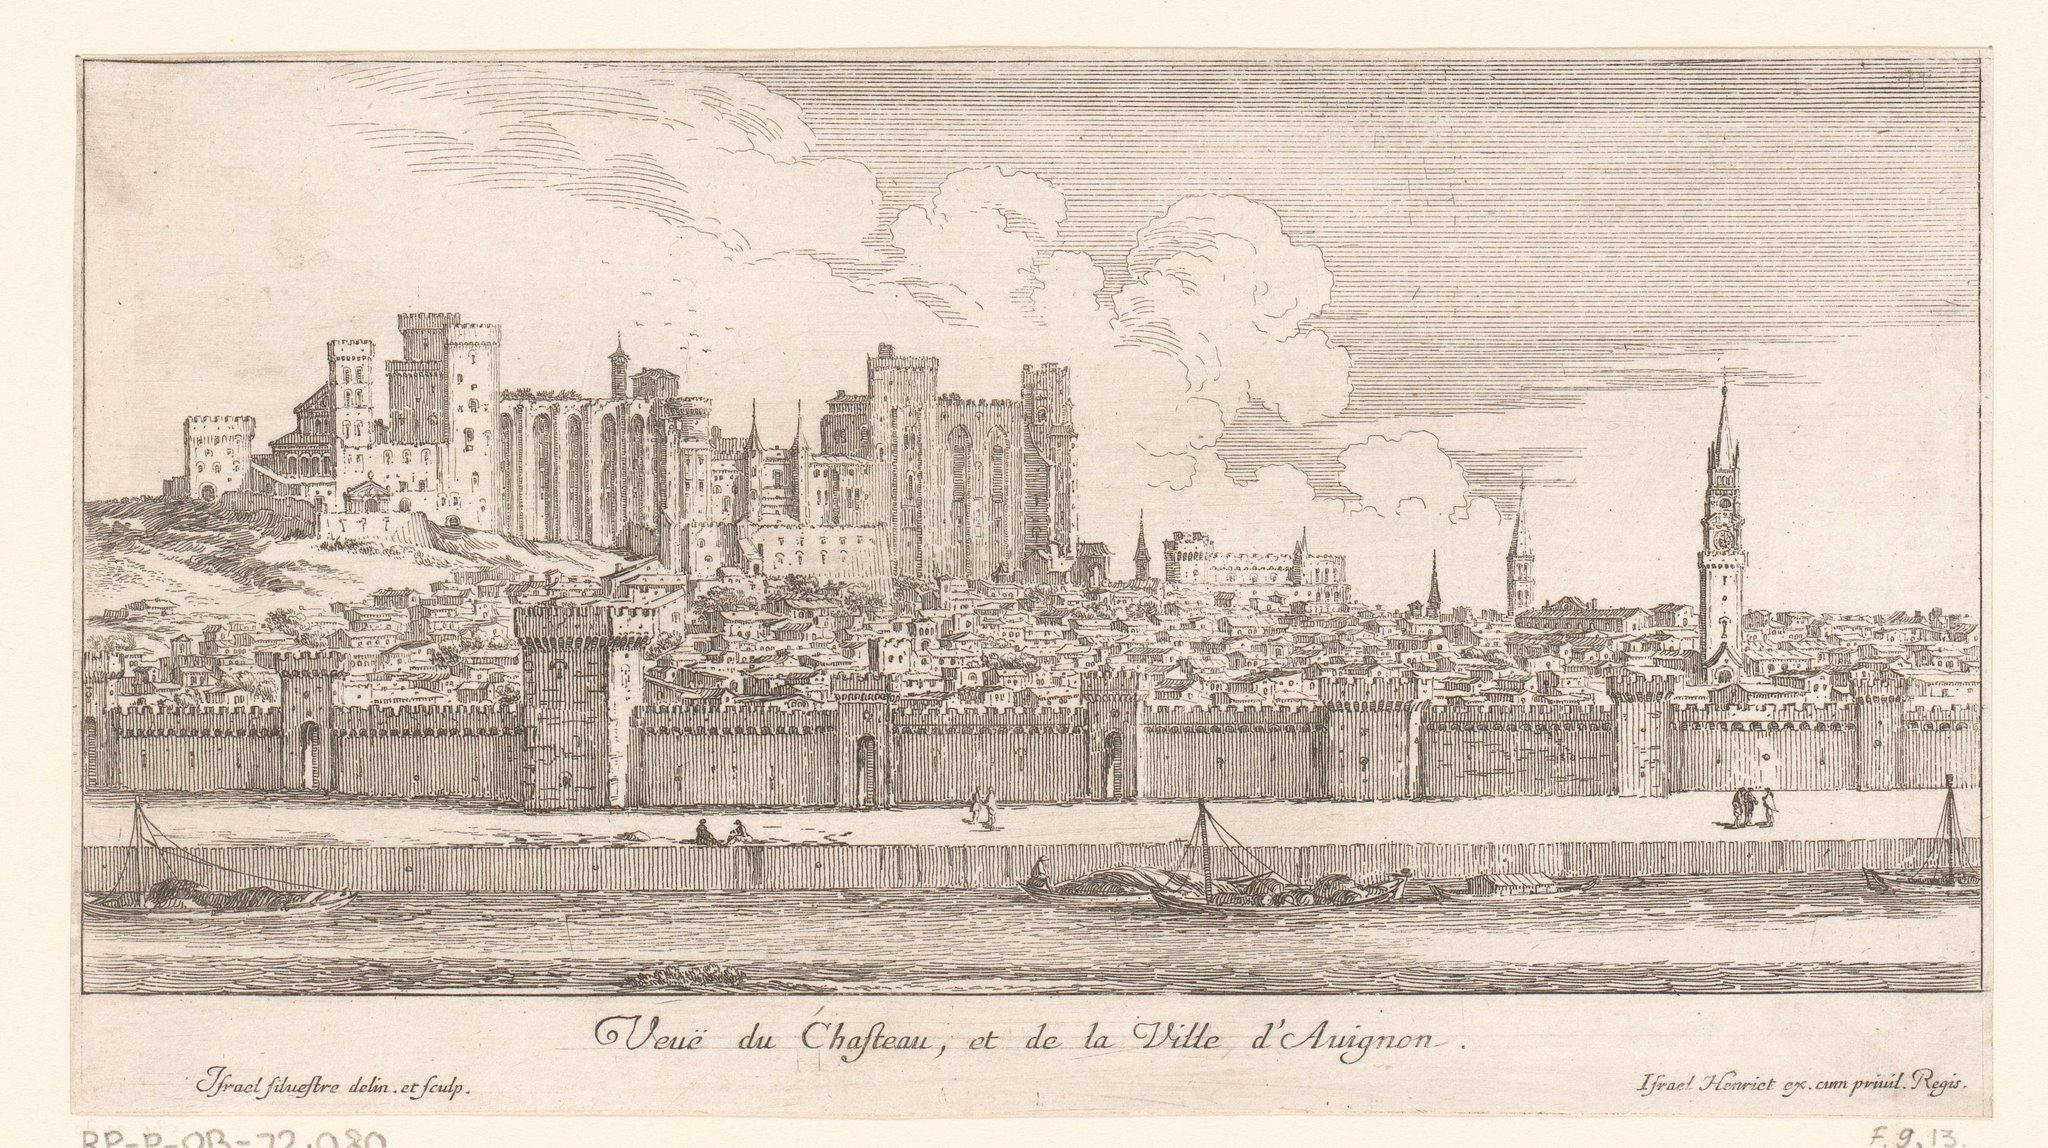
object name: print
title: Vues d'Italie et de France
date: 1654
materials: paper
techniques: etching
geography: france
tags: city-view in general; 'veduta', landscape with tower or castle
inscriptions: collector's mark: Lugt 240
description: Prent maakt deel uit van een serie van zestien prenten, deels ongenummerd.